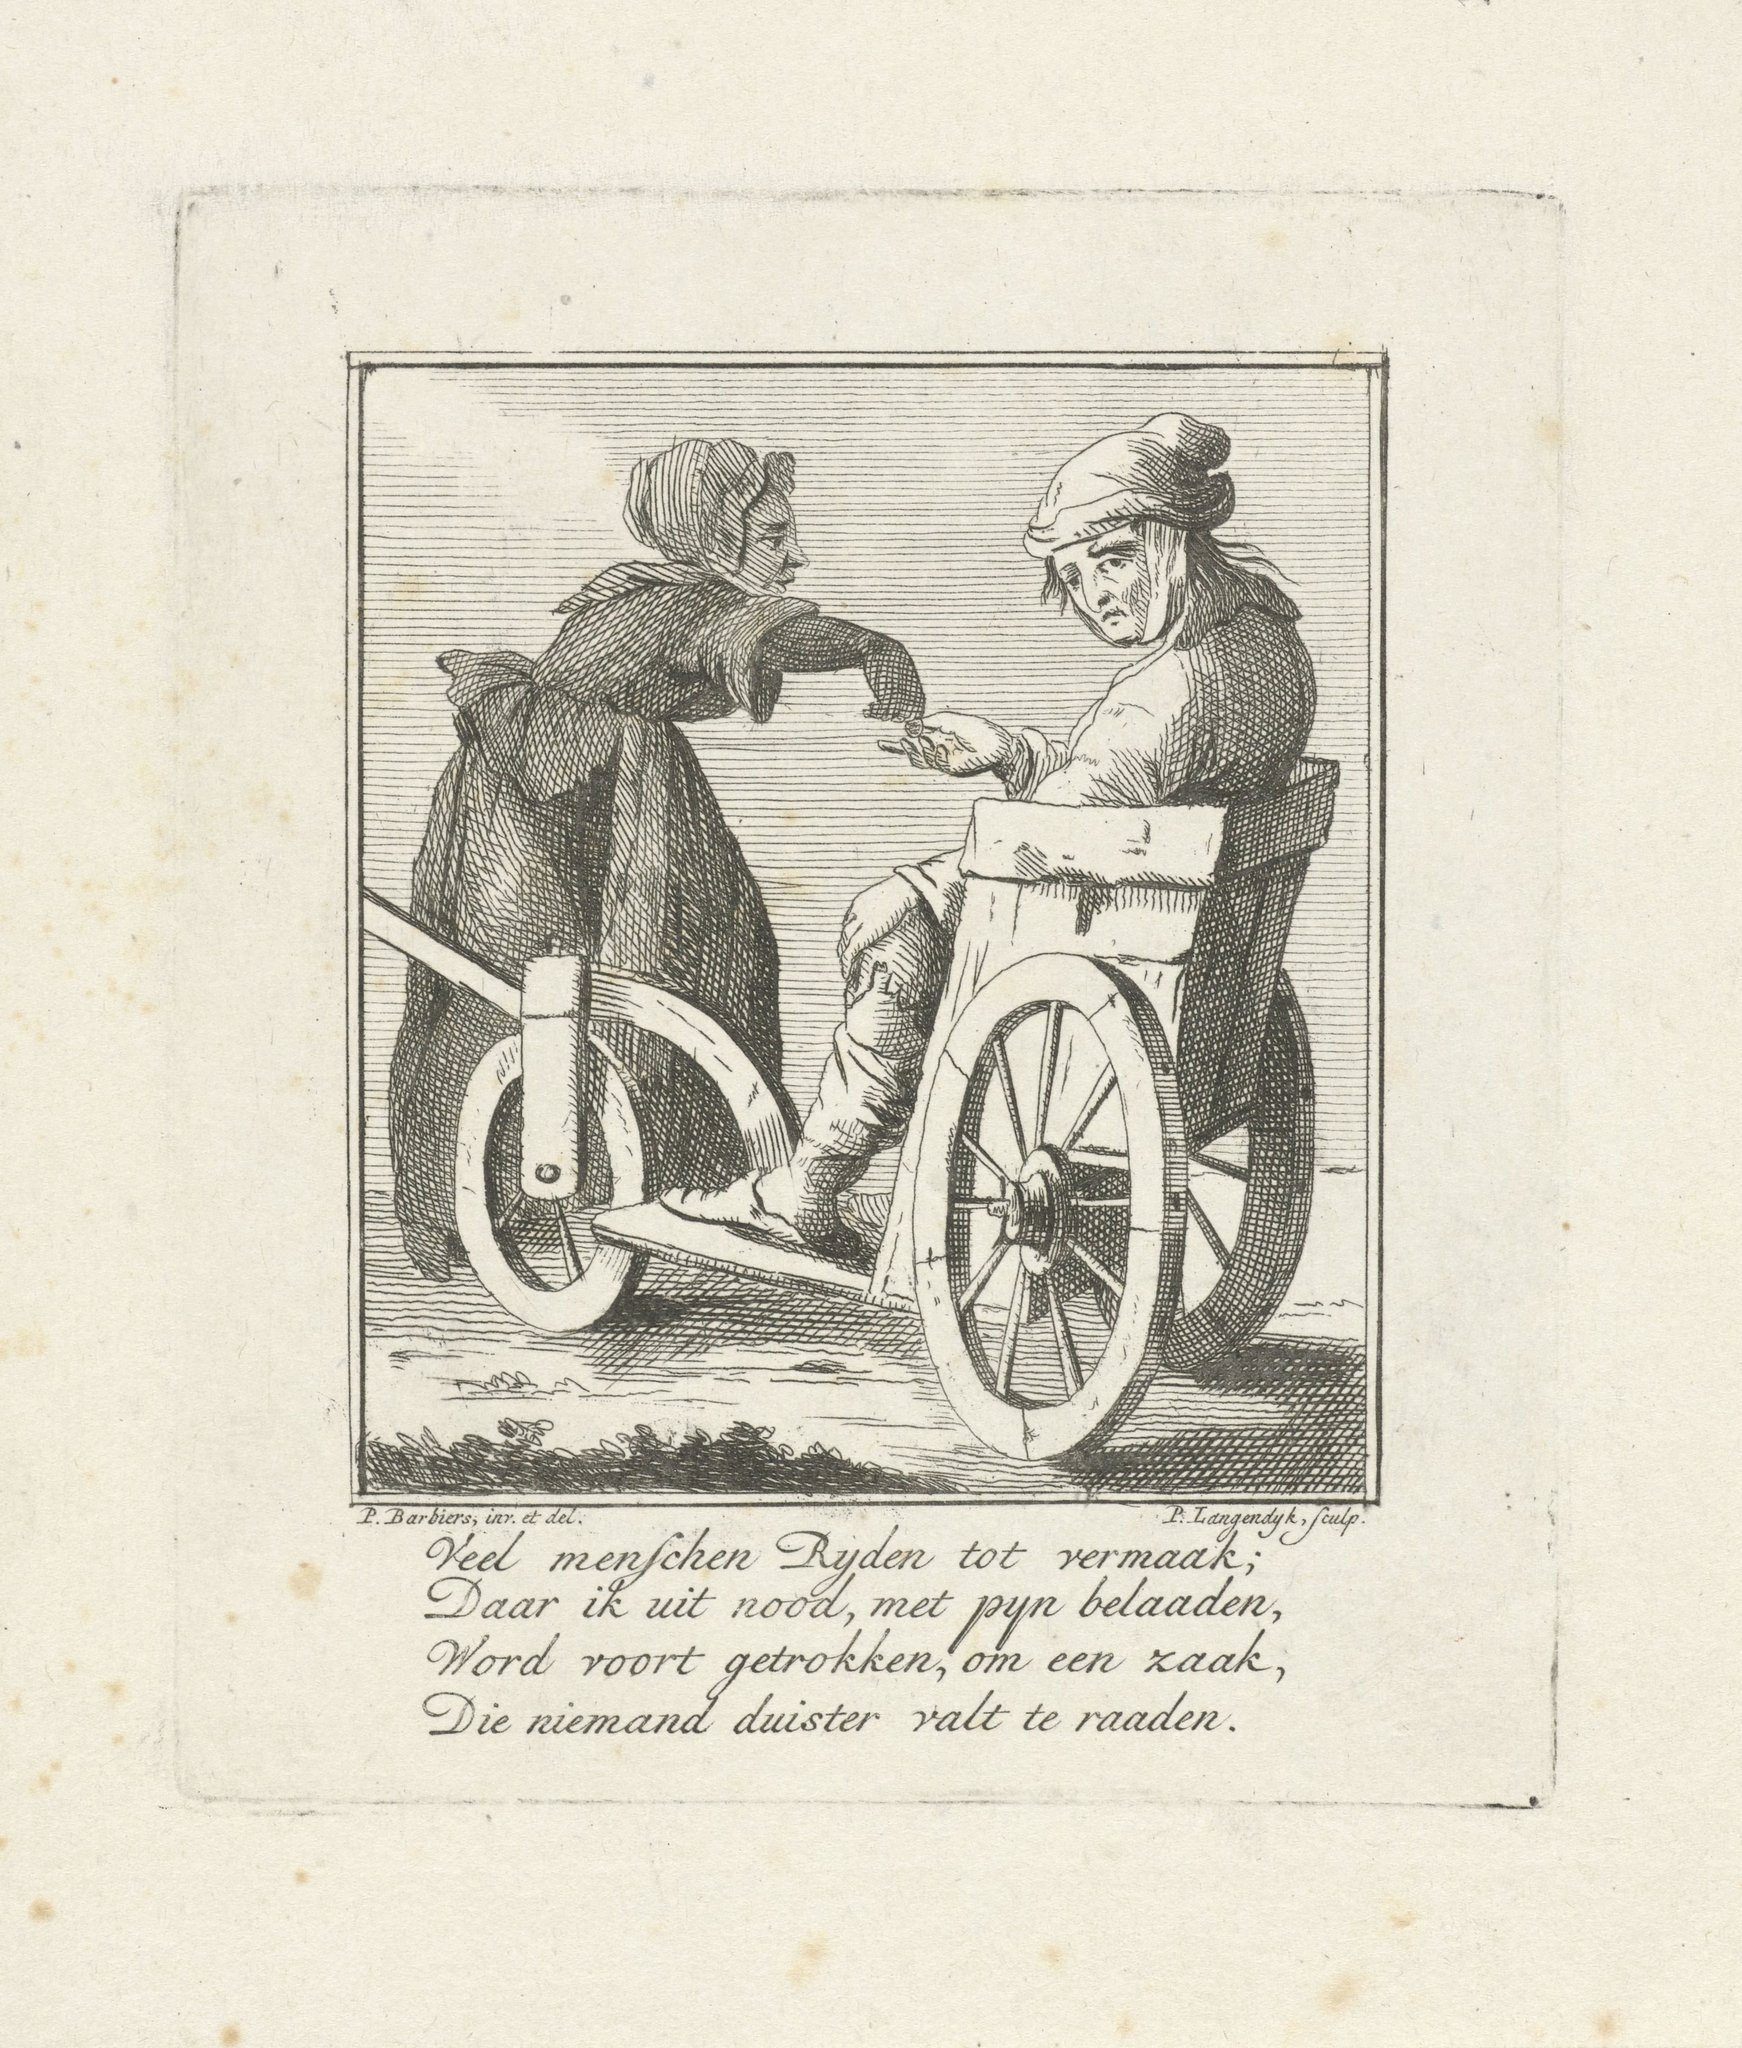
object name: print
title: Kreupele man in driewielig karretje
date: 1770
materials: paper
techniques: engraving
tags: giving alms or other charity, e.g.: handing out food, person with a physical disability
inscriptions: : ‘Veel menschen Rijden tot vermaak;/ Daar ik uit nood, met pijn belaaden,/ word voort getrokken, om een zaak,/ Die niemand duister valt te raaden.’, collector's mark: Lugt 240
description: Een man in een kar, een soort rolstoel met drie wielen, ontvangt munten van een vrouw. In de marge een vierregelig vers in het Nederlands. Onderdeel van een serie van prenten van Amsterdamse straatfiguren rond 1770.